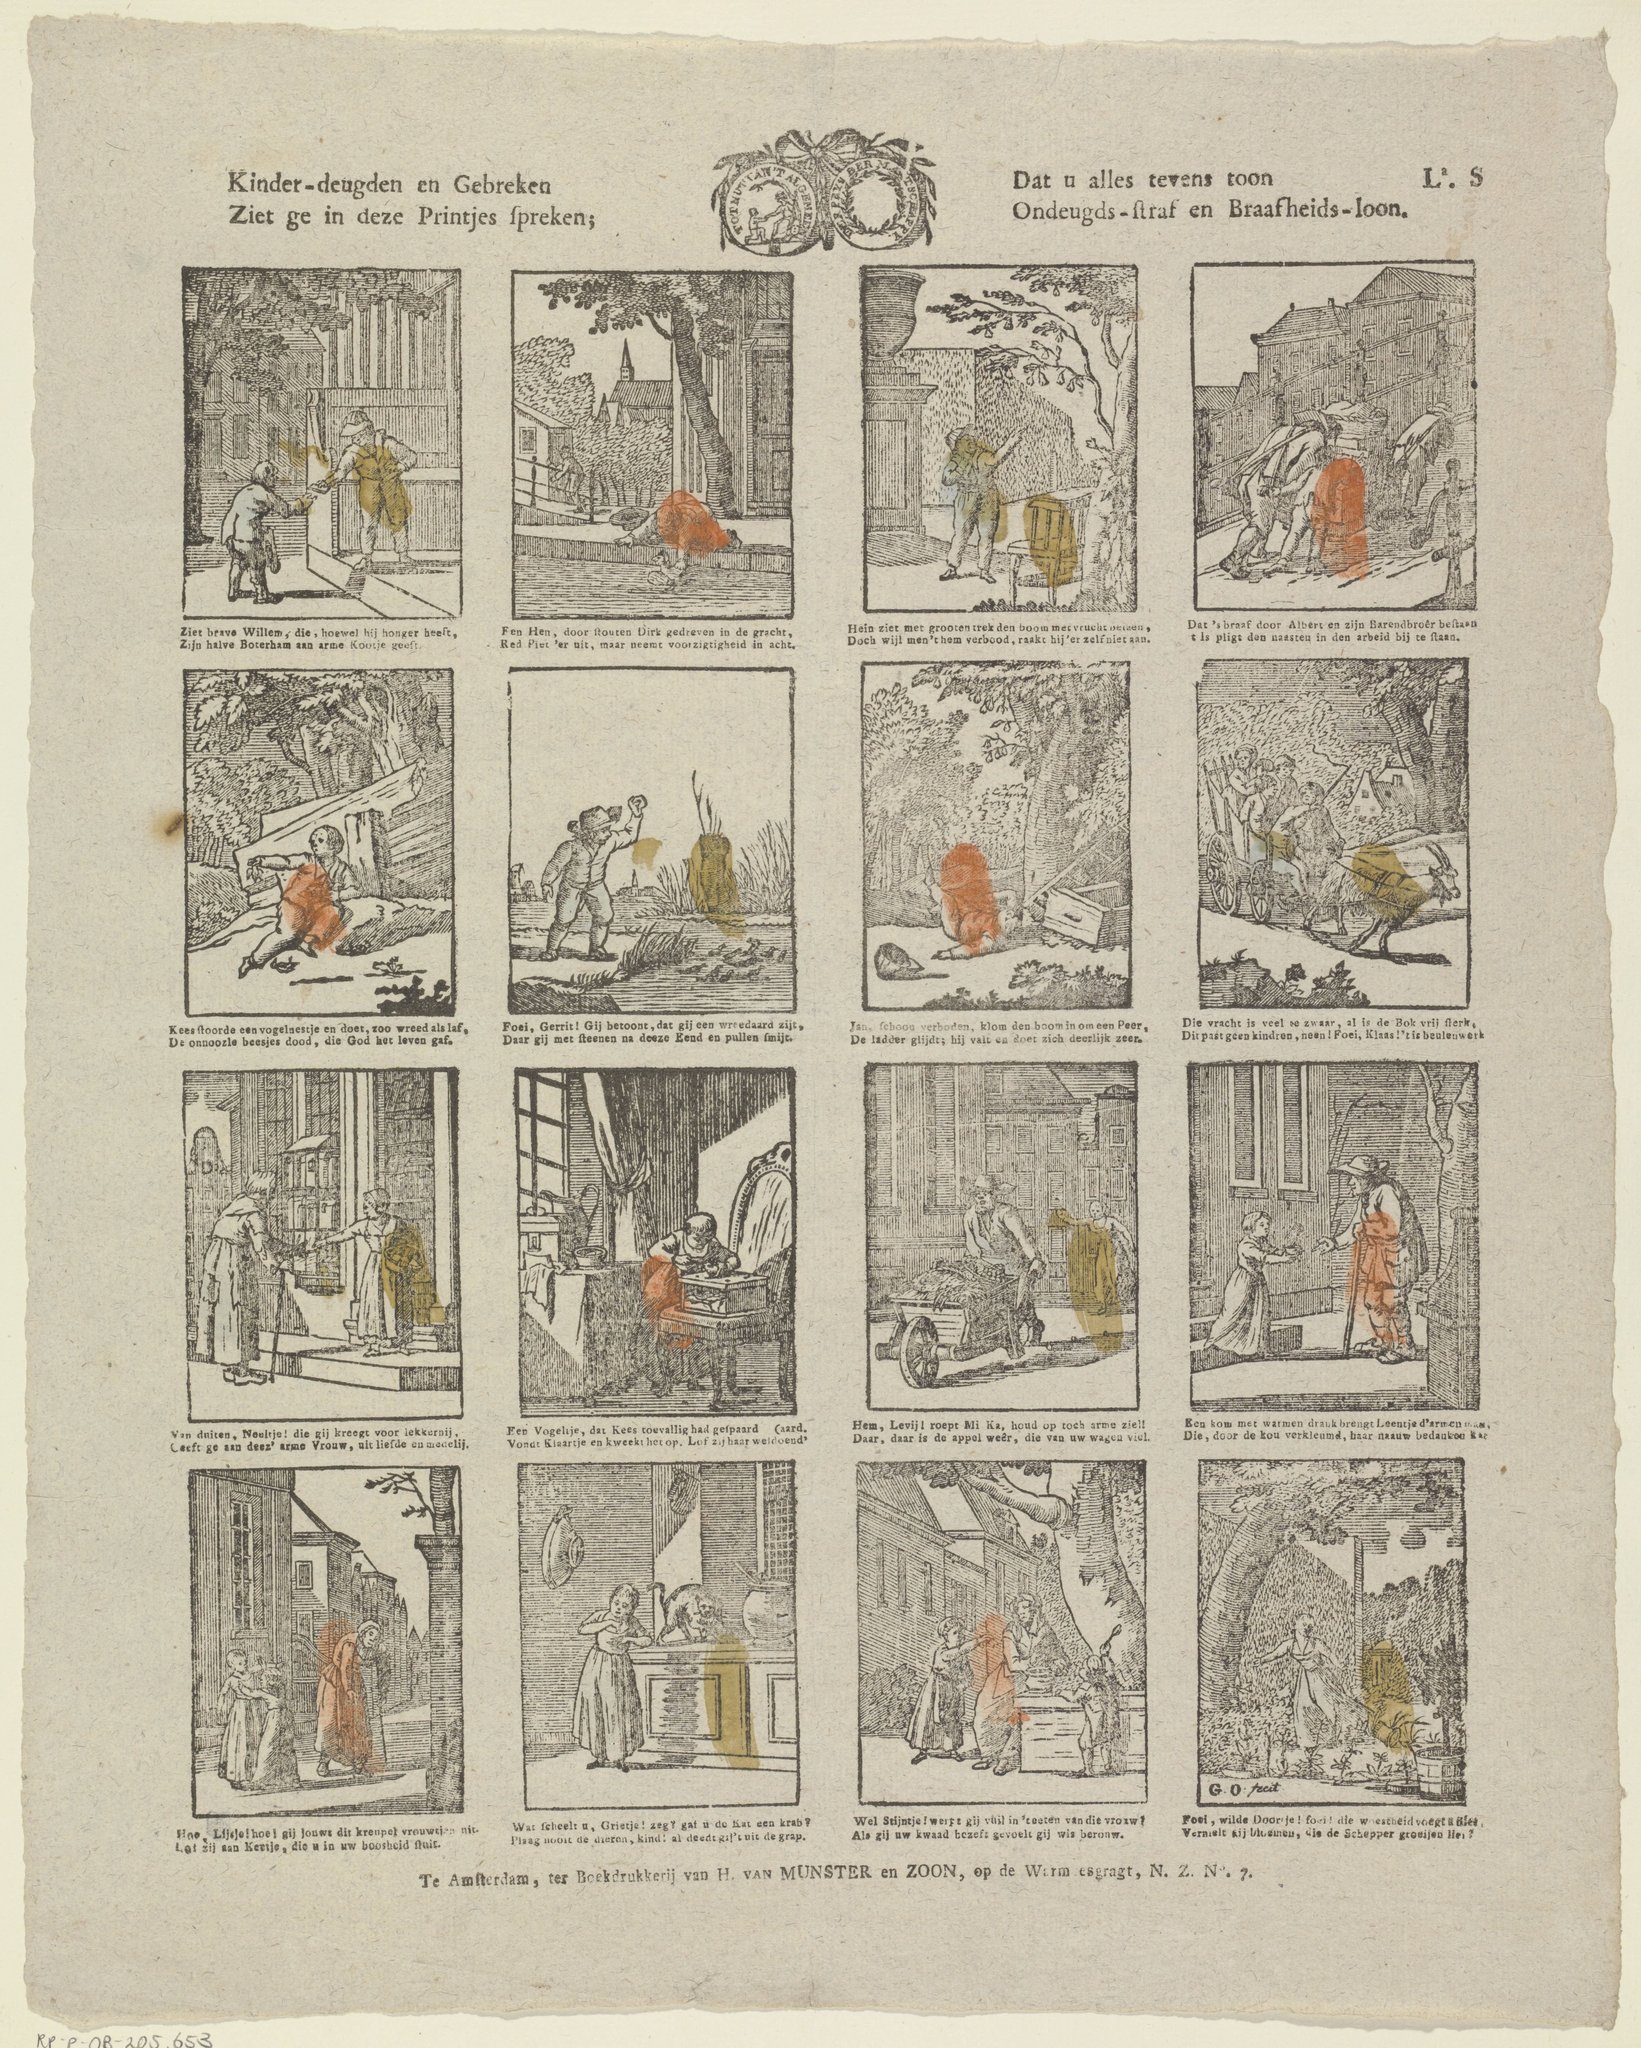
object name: print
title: Kinder-deugden en gebreken / Ziet ge in deze printjes spreken; / Dat u alles tevens toon / Ondeugds-straf en braafheids-loon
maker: gerrit oortman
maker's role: print maker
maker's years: 1781-1822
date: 1811-1829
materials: paper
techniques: colour, letterpress printing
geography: amsterdam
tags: good and bad behaviour, moral qualities (opposing concepts) (+ situation or event (especially in genre-painting) with symbolical connotation), child (at home)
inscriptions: collector's mark: Lugt 2760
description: Blad met 12 voorstellingen van de beloning van gehoorzame kinderen en de bestraffing van ongehoorzame kinderen. Midden boven het zegel van de Maatschappij tot Nut van 't Algemeen. Onder elke afbeelding een tweeregelig ver. Genummerd rechtsboven: L.S.